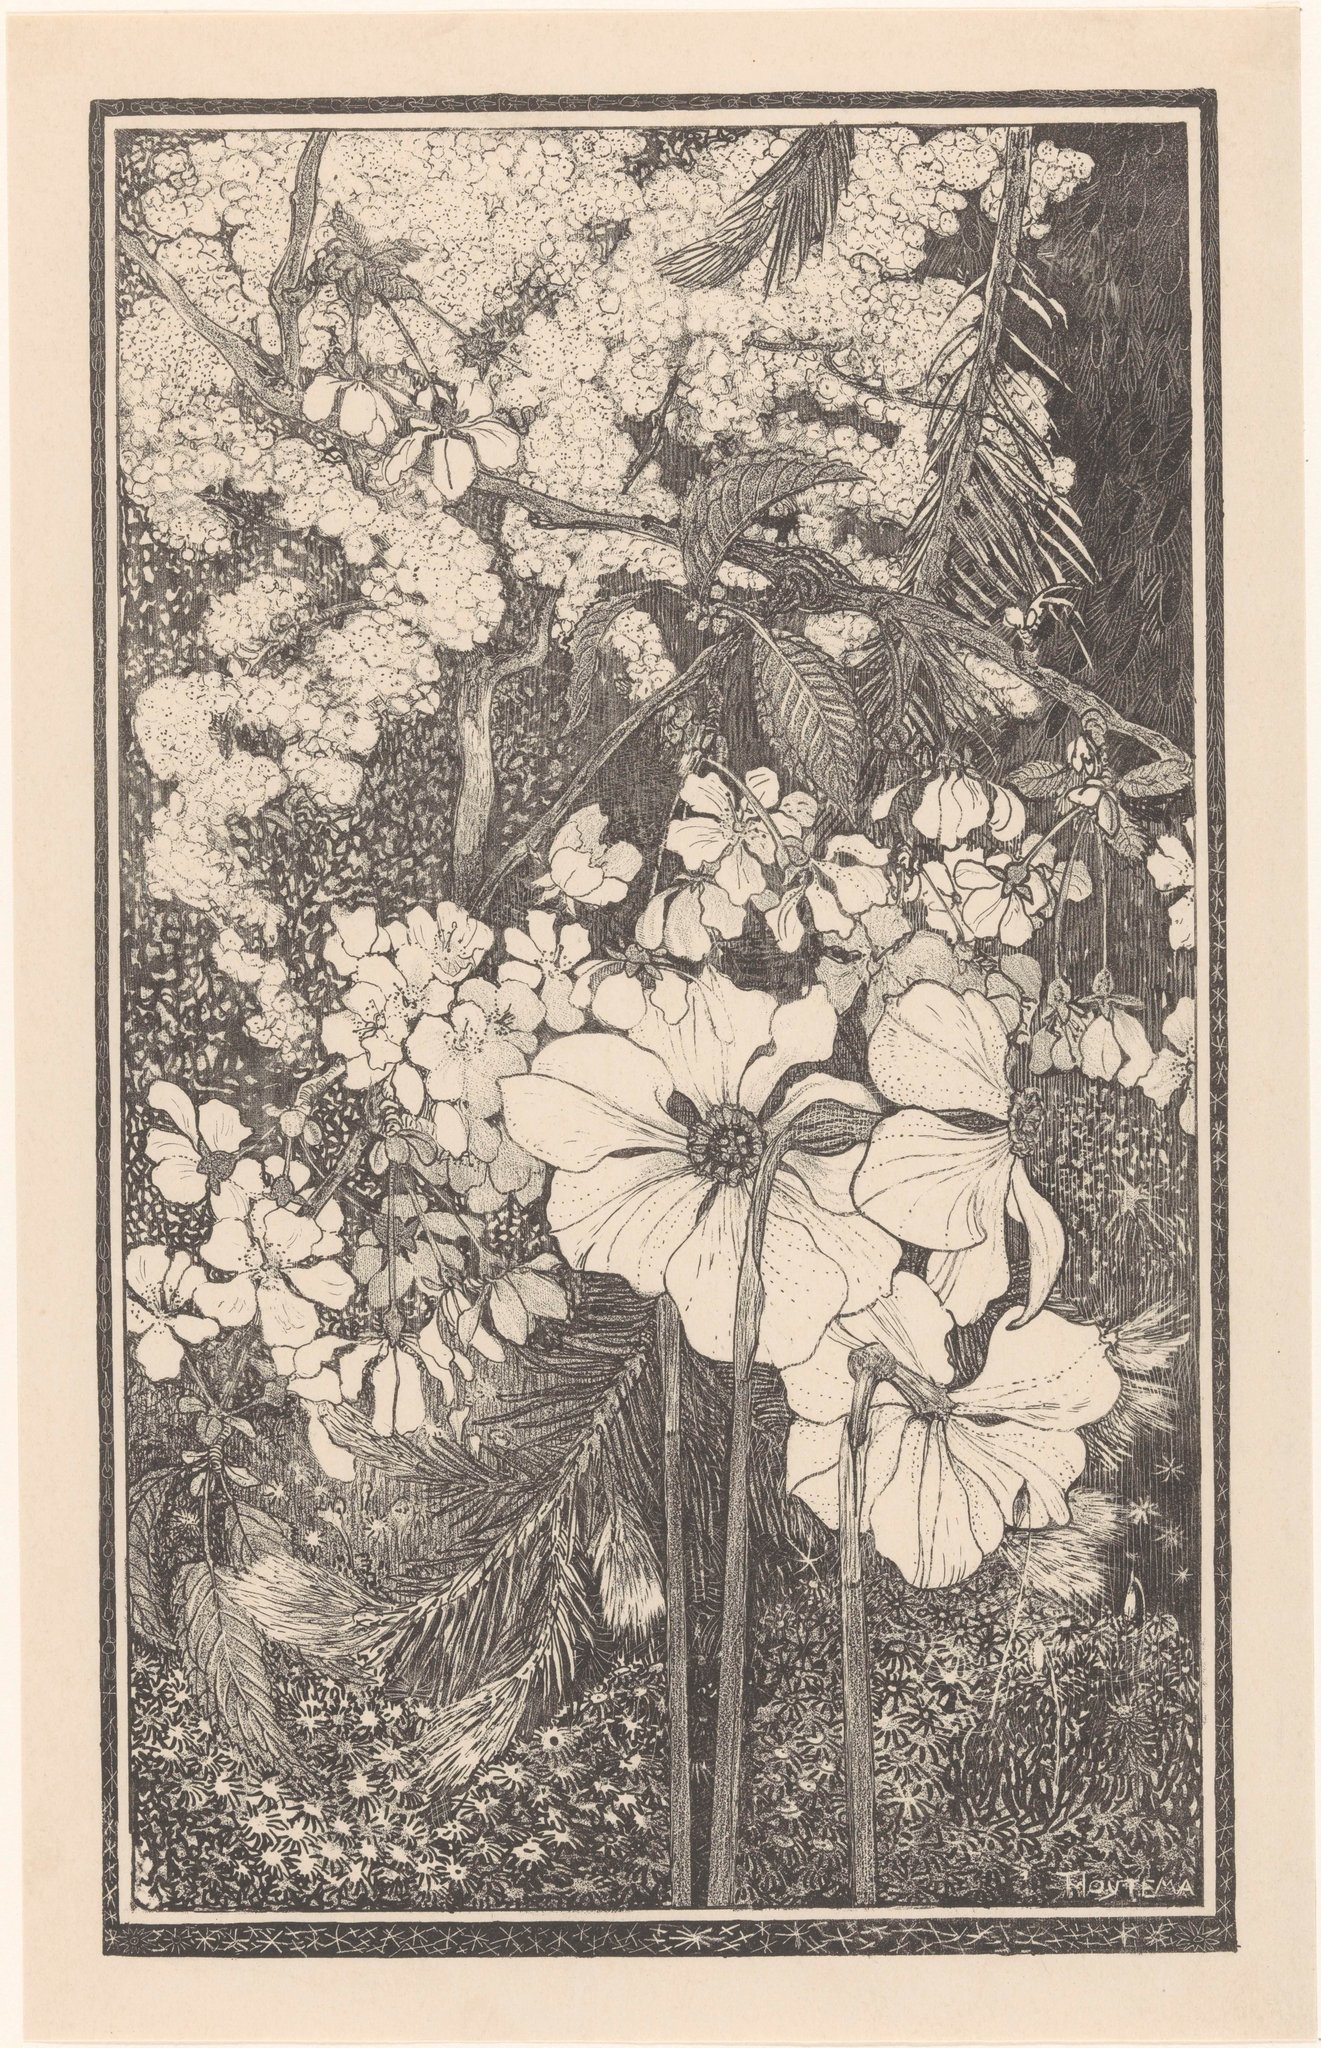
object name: print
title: Lente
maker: theo van hoytema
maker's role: draughtsman, painter, print maker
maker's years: 1863-1917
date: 1878-1914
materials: paper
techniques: lithograph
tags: flowers: narcissus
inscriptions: collector's mark: Lugt 2233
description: Prent gebruikt voor: Tak, P.L. De kroniek. Een algemeen weekblad. Amsterdam: C.M. van Gogh, 10 oktober 1897. De prent verscheen als bijlage met als titel 'Lente'.